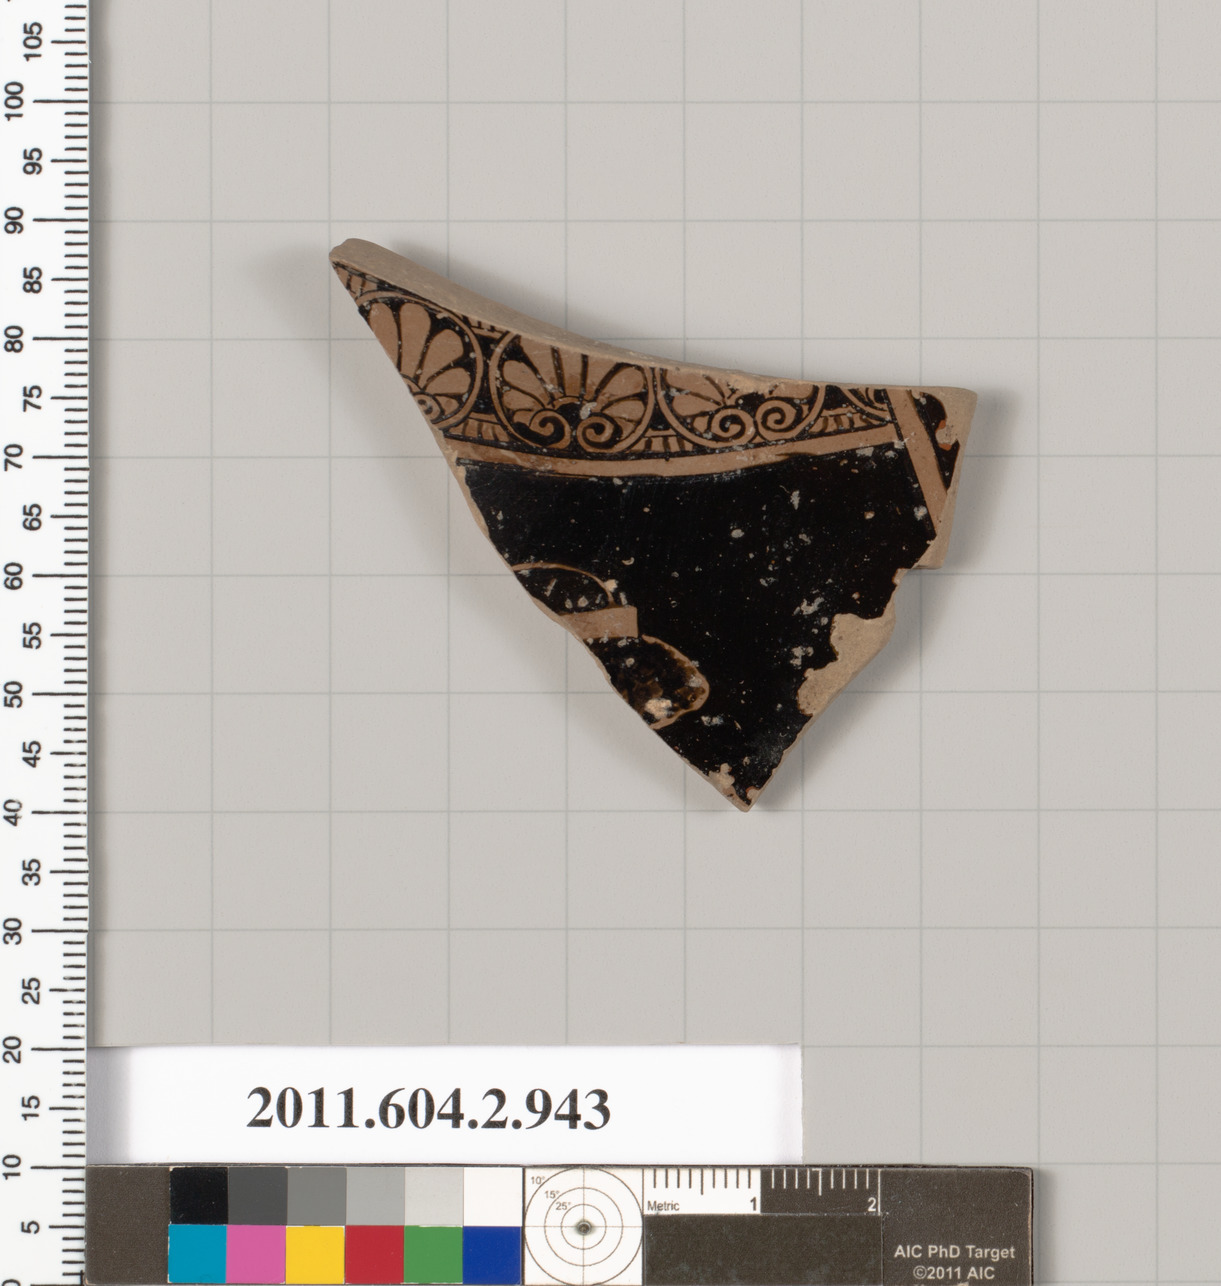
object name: oinochoe fragment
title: Terracotta fragment of an oinochoe (jug)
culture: greek, attic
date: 475-451 BCE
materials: terracotta